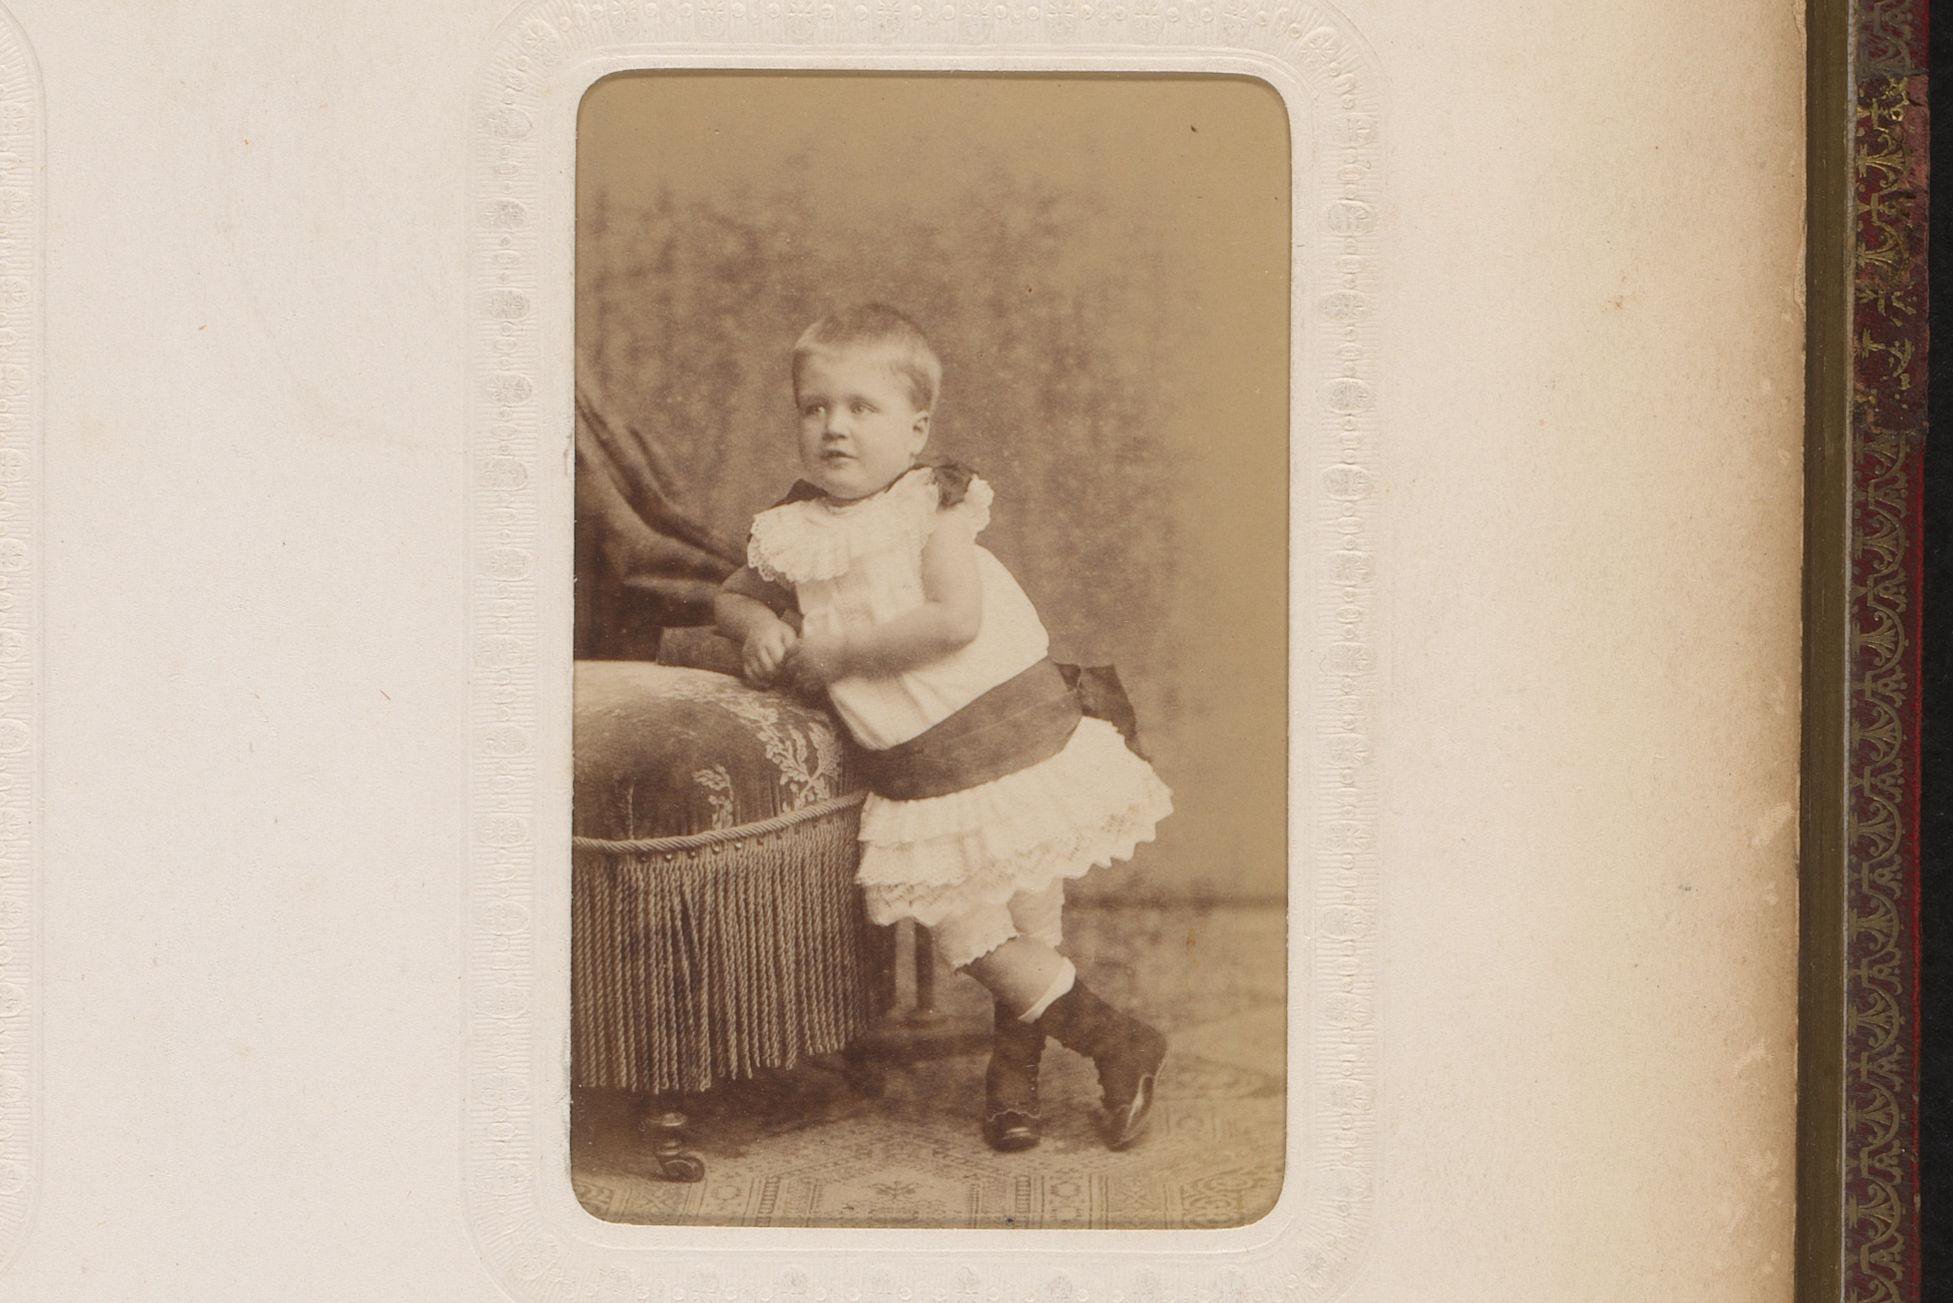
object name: album leaf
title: Portret van een jongen, staand achter een hek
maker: Anonymous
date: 1860-1900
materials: cardboard, photographic support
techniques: albumen print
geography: netherlands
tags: standing figure, boy (child between toddler and youth), fence, wall, paling, historical persons